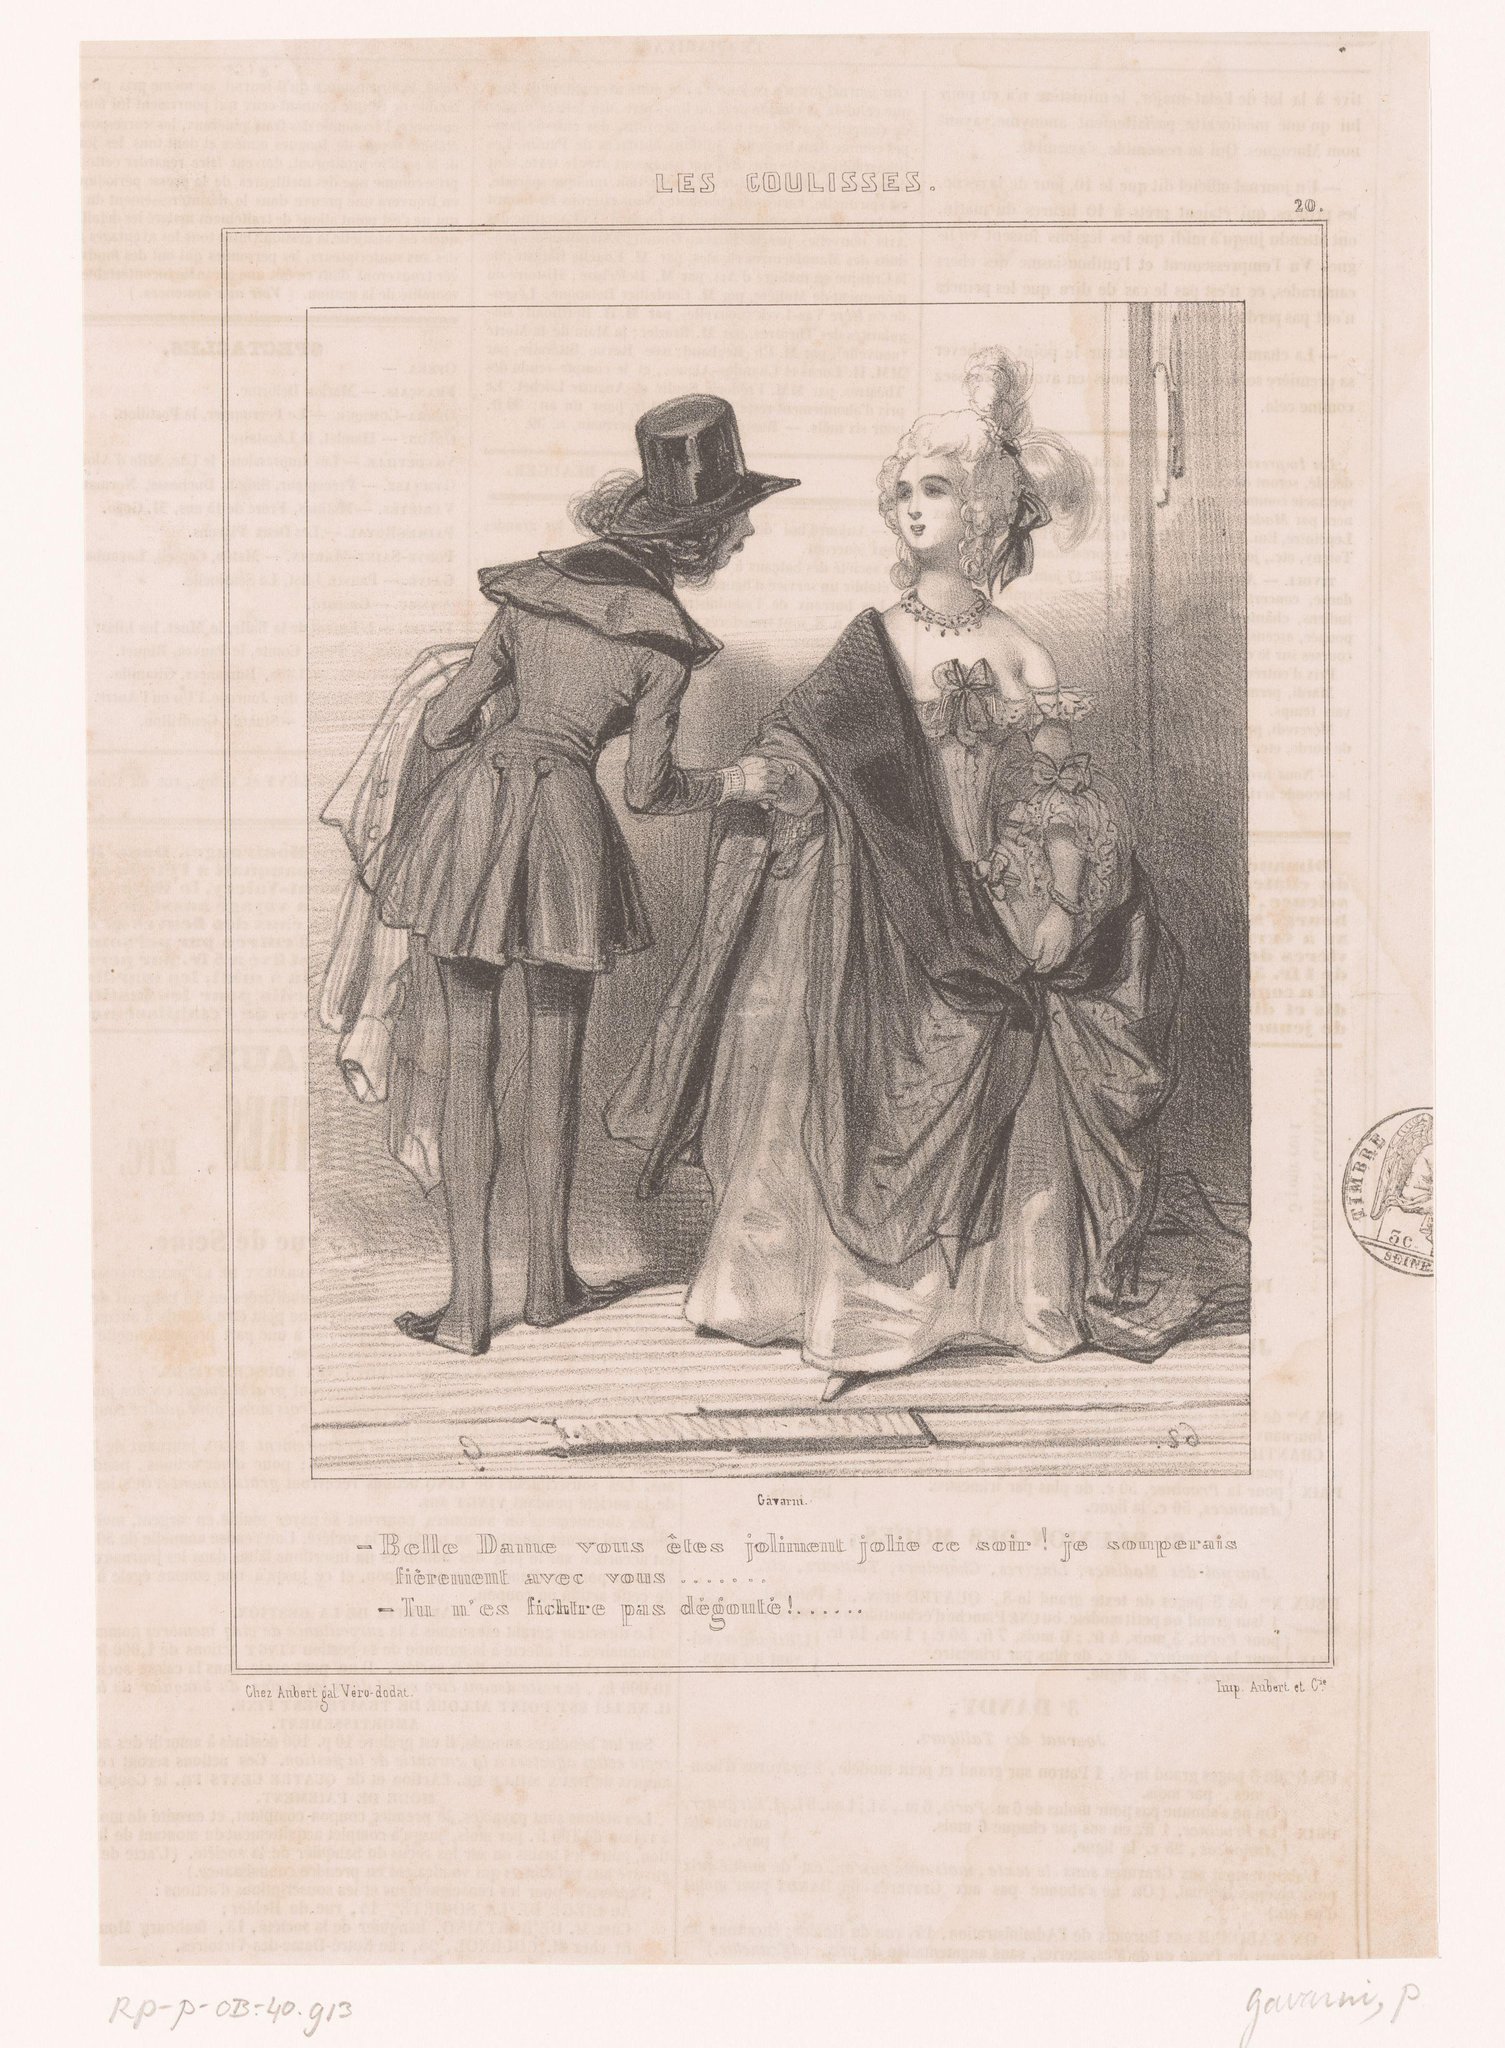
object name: print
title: Belle Dame vous êtes joliment jolie ce soir! (...)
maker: paul gavarni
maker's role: draughtsman, print maker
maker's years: 1804-1866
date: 1838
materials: paper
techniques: lithograph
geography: paris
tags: behind the stage, artiste in other non-work situation, courting, stage costume - cc - female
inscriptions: stamp: ‘Timbre Royal/ 3c./ Seine’, collector's mark: Lugt 2228a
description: Prent gebruikt voor: Le Charivari, 17 juni 1838.